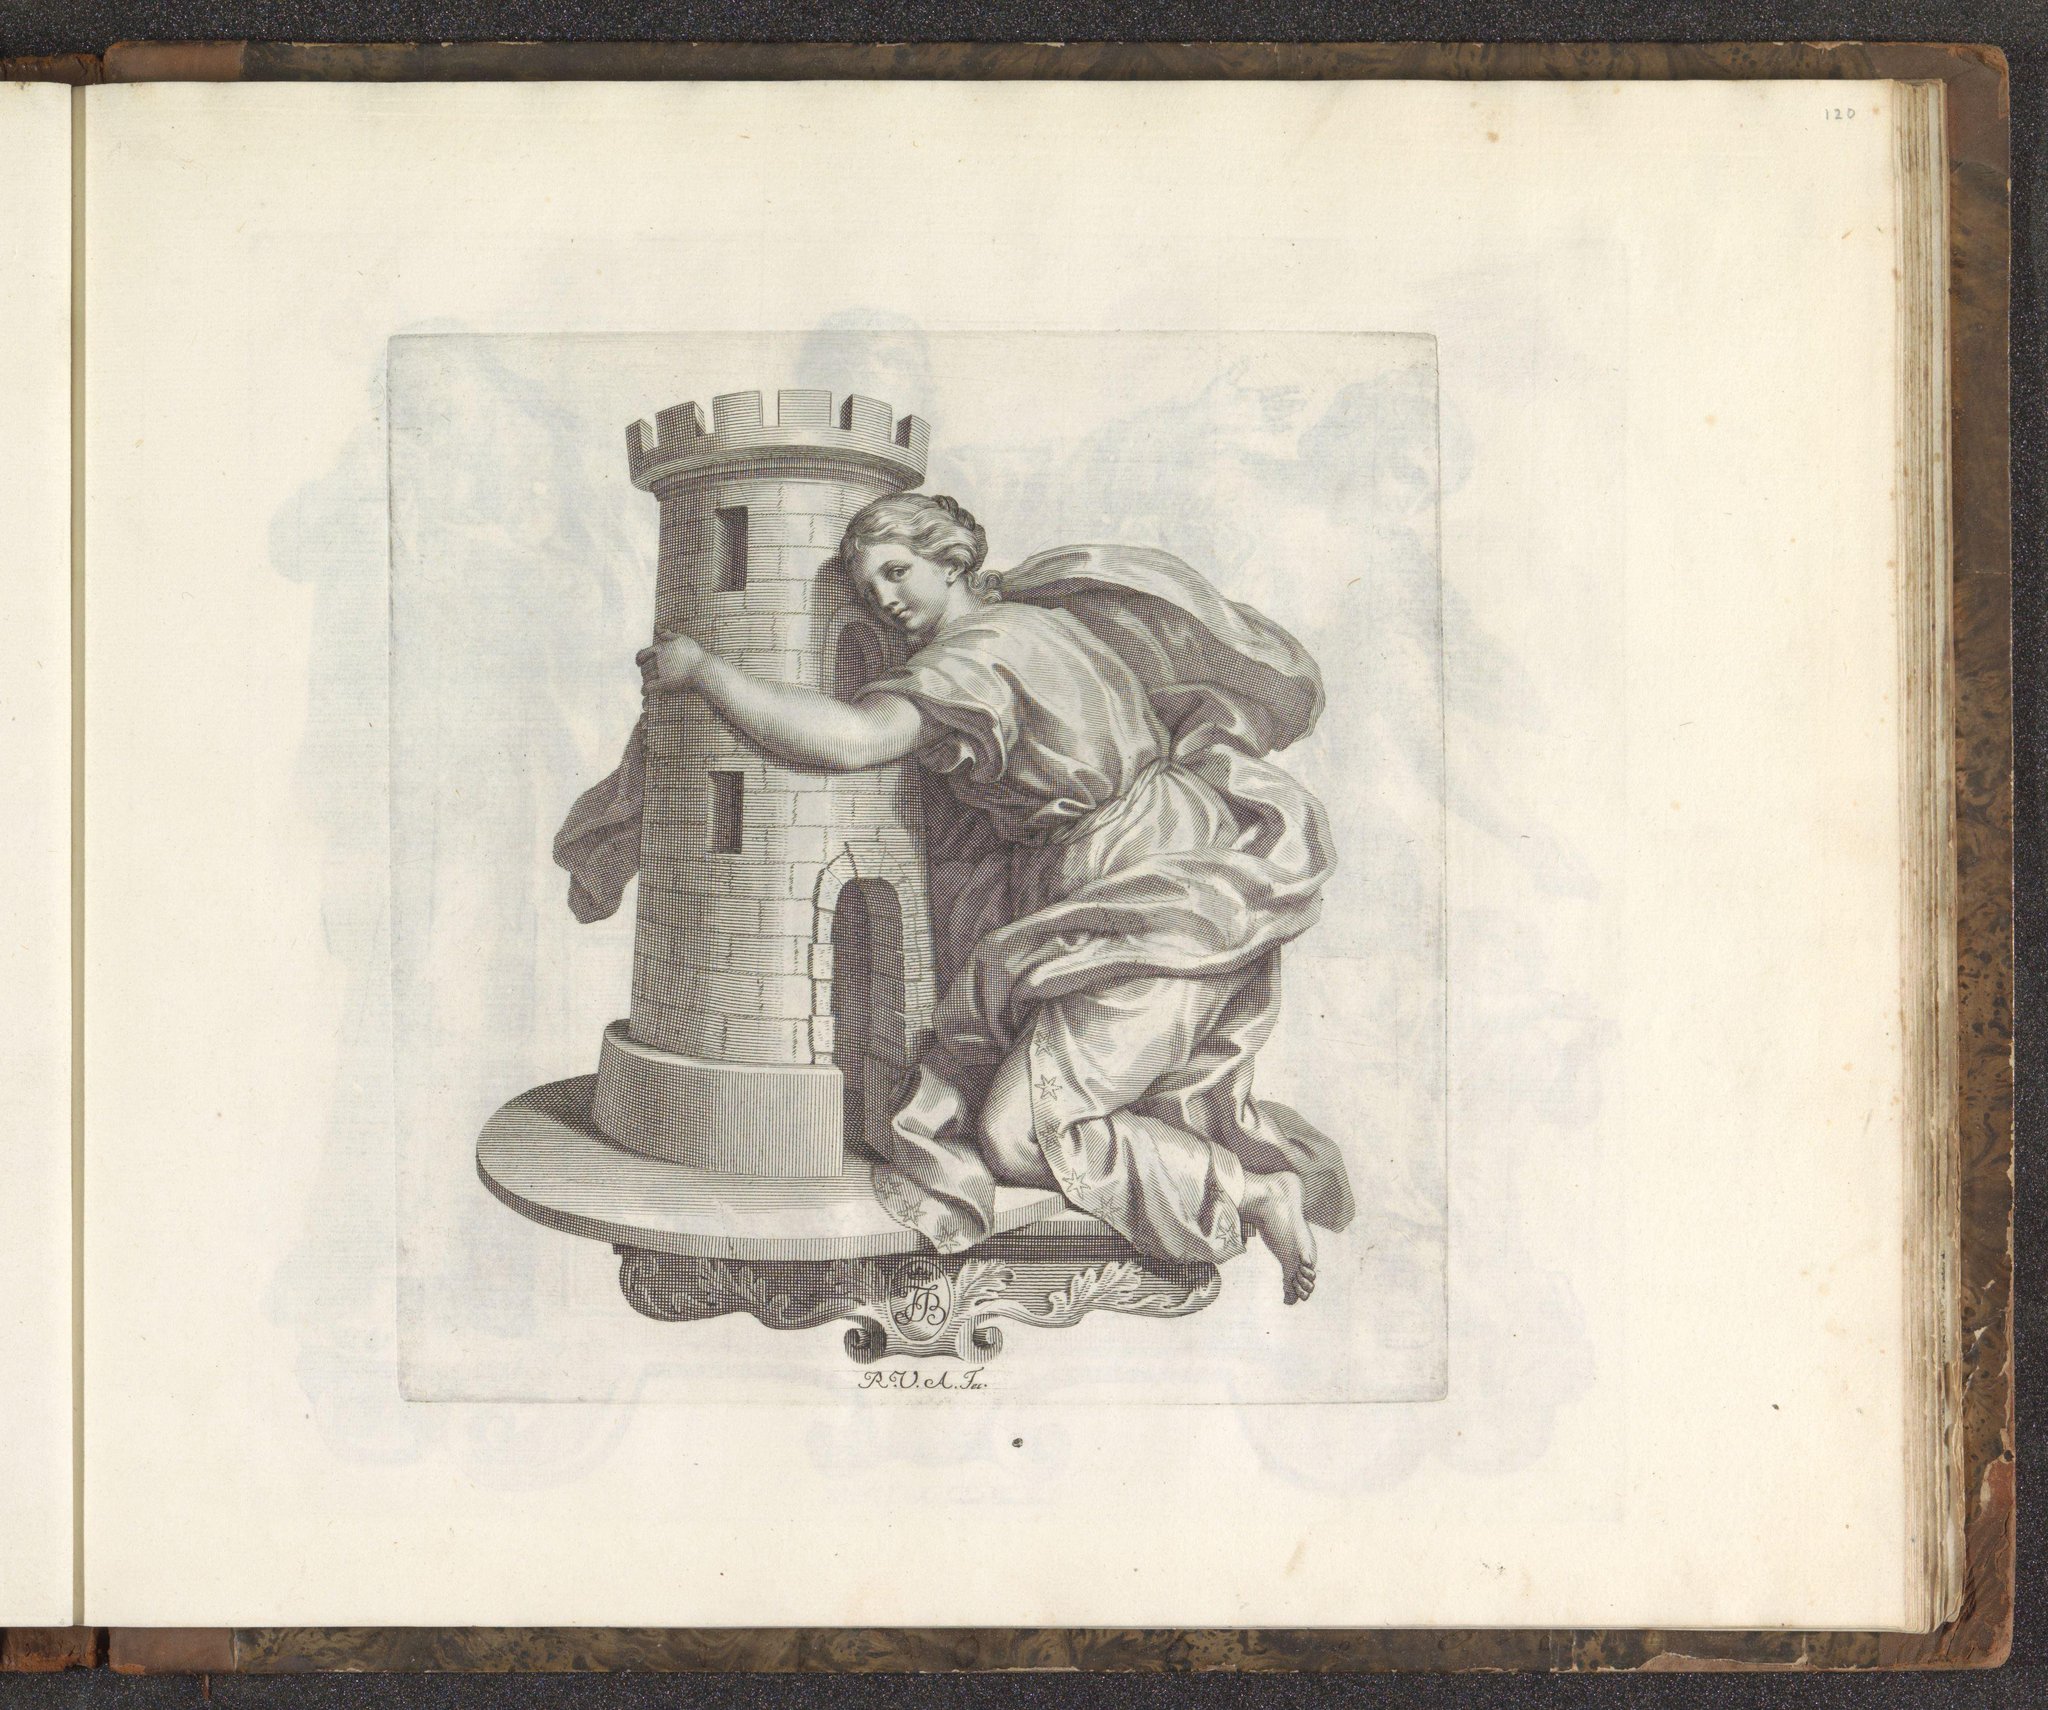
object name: album leaf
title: Numismata virorum illustrium ex Barbadica gente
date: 1673-1743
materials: paper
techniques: engraving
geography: rome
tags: tower, clock tower ~ monumental adornment, female sex; woman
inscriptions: collector's mark: Lugt 2228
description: Een console met een vrouw, gekleed in een mantel met enkele sterren bij de zoom. Ze omarmt een toren of kasteel. De prent maakt deel uit van een album.